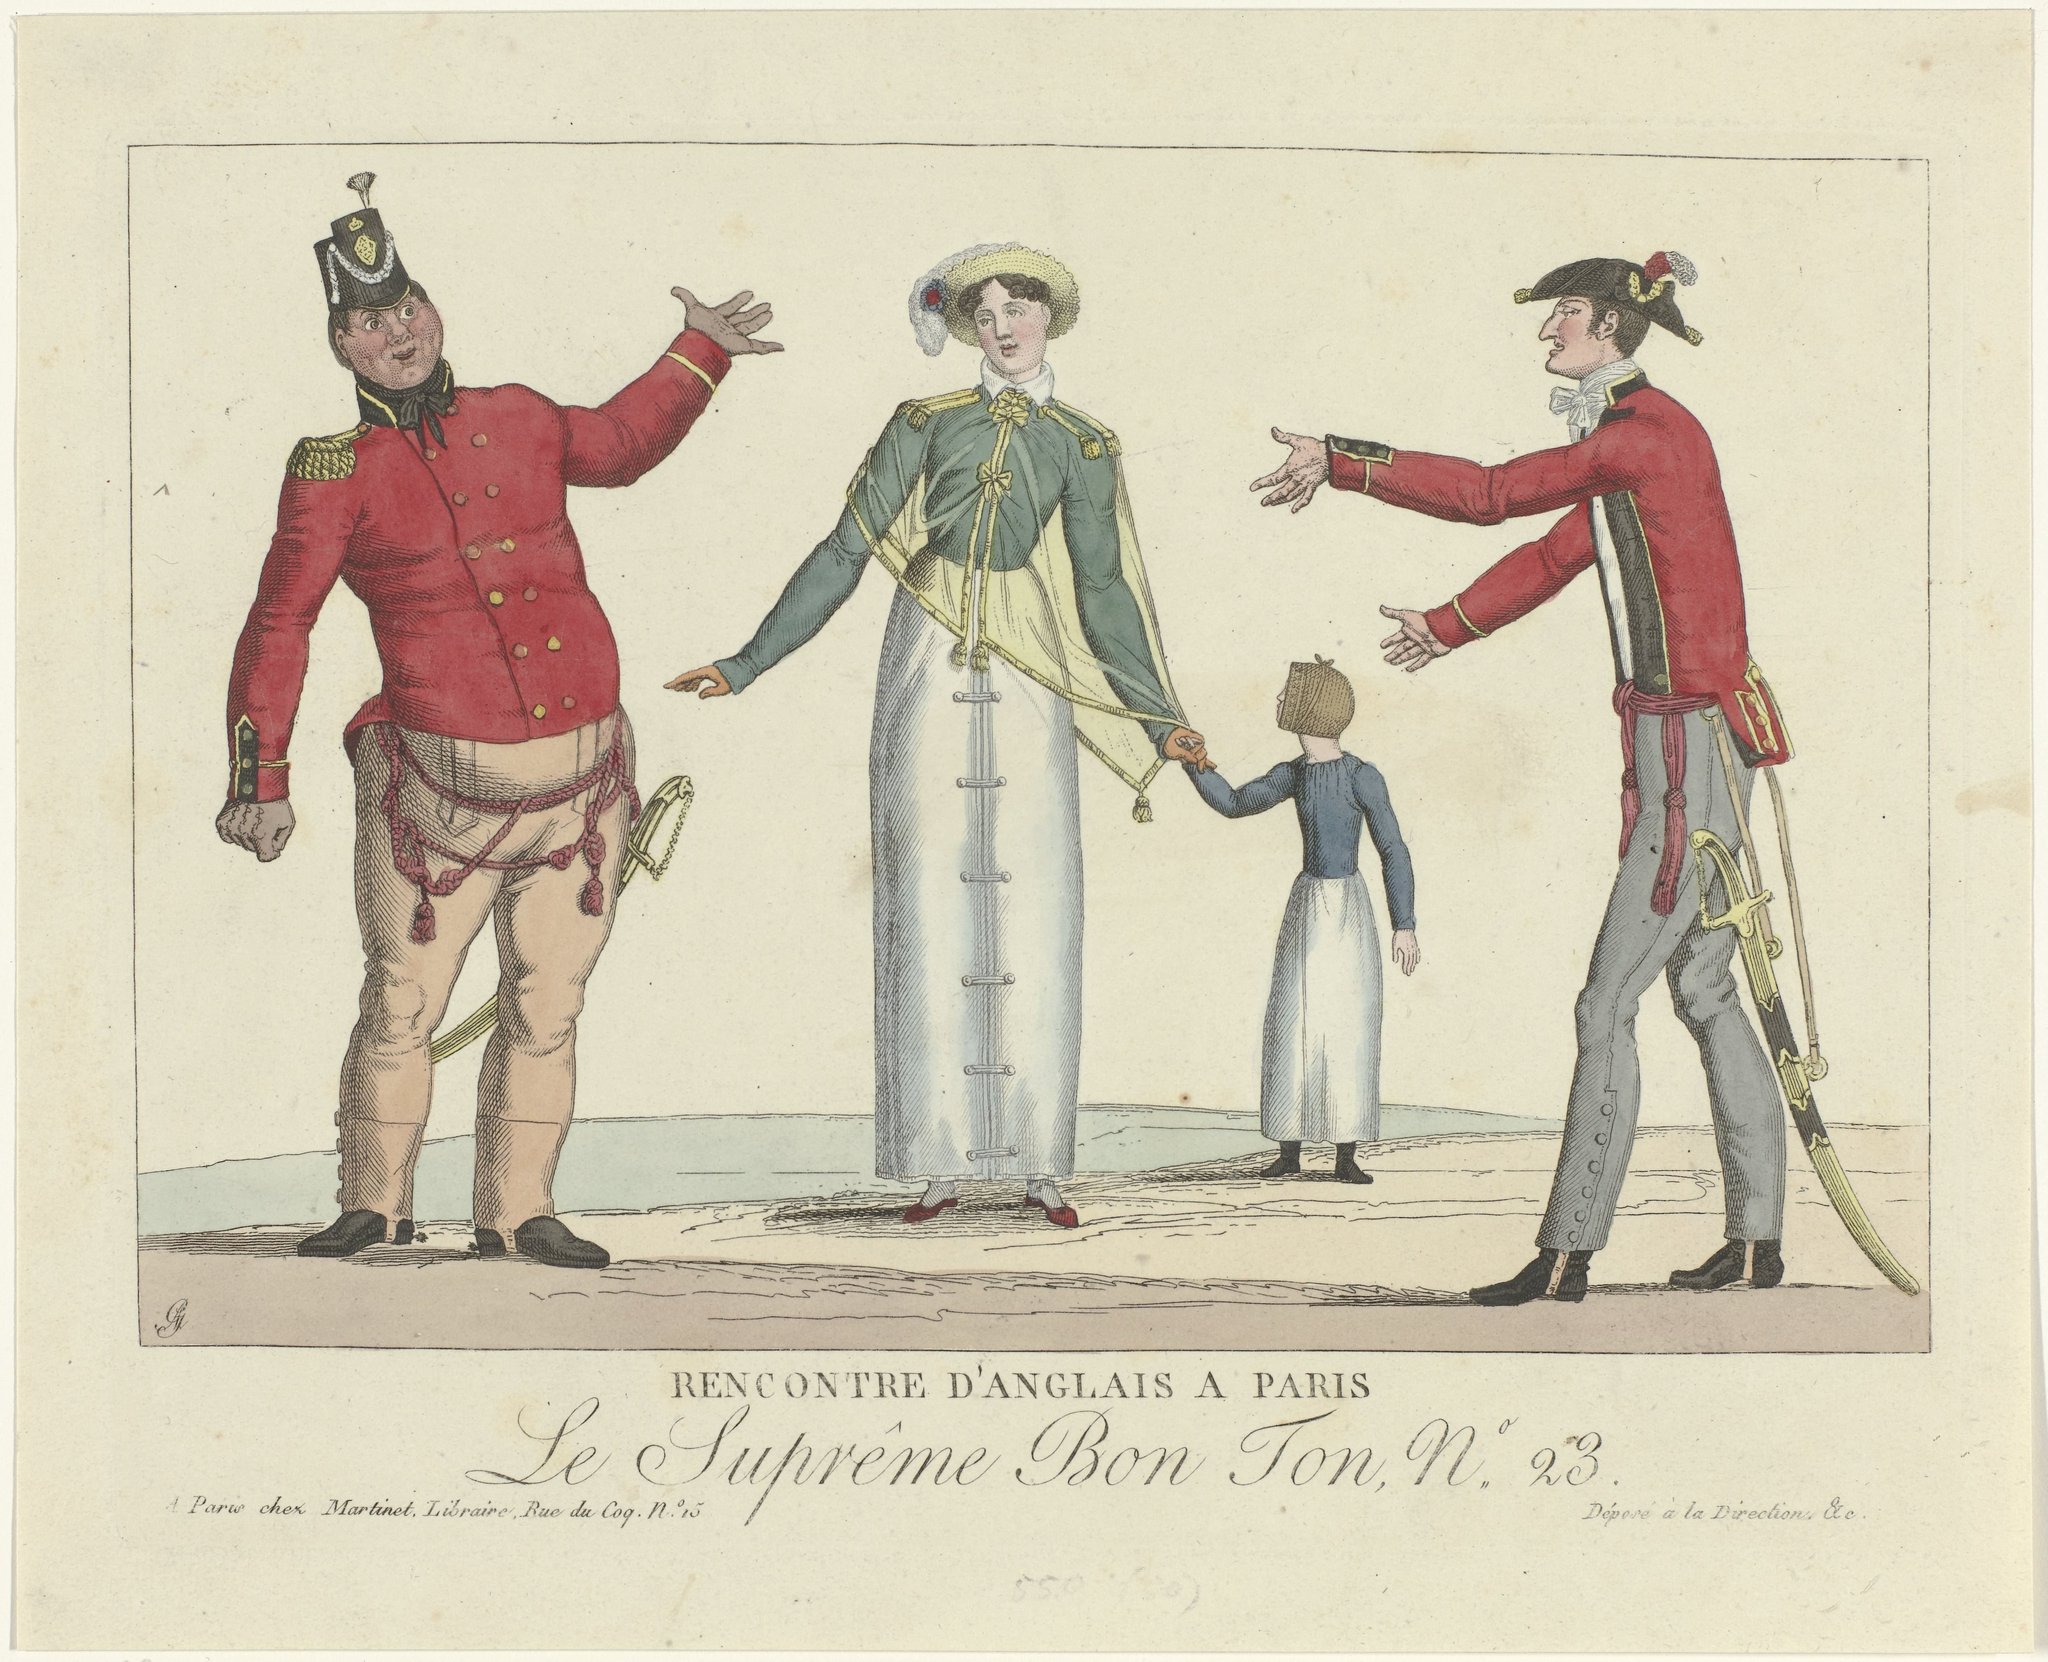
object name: fashion print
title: Le Suprême Bon Ton, 1800-1815, No. 23: Rencontre d'anglais à Paris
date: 1800-1815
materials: paper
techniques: etching, hand coloring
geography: paris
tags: meeting of soldiers and/or officers (+ variant), clothes, costume (+ girls' clothes), cape (+ women's clothes), clothing for the upper part of the body (spencer) (+ women's clothes), europeans: englishmen, fashion plates, head-gear: hat (+ women's clothes), skirt (+ women's clothes), (military) uniforms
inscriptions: title: ‘Le Suprême Bon Ton, No. 23.’, address: ‘A Paris chez Martinet, Libraire, Rue du Coq, No. 15’, inscription: ‘Dépose à la Direction, & c.’, caption: ‘RENCONTRE D'ANGLAIS A PARIS’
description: Twee militairen gekleed in Engelse uniformen. Beiden dragen een uniformjas op een lange spanbroek. De dikke man heeft op het hoofd een sjako; de slanke man een steek met struisveer en aan de uiteinde troetels. Tussen hen in staat een vrouw met aan de hand een meisje. Zij draagt een doorzichtige cape over een spencer. Volgens het onderschrift ontmoeten de Engelsen elkaar in Parijs. Prent uit een serie van 30 modeprenten, Le Suprême Bon Ton, Parijs, 1800-1815.